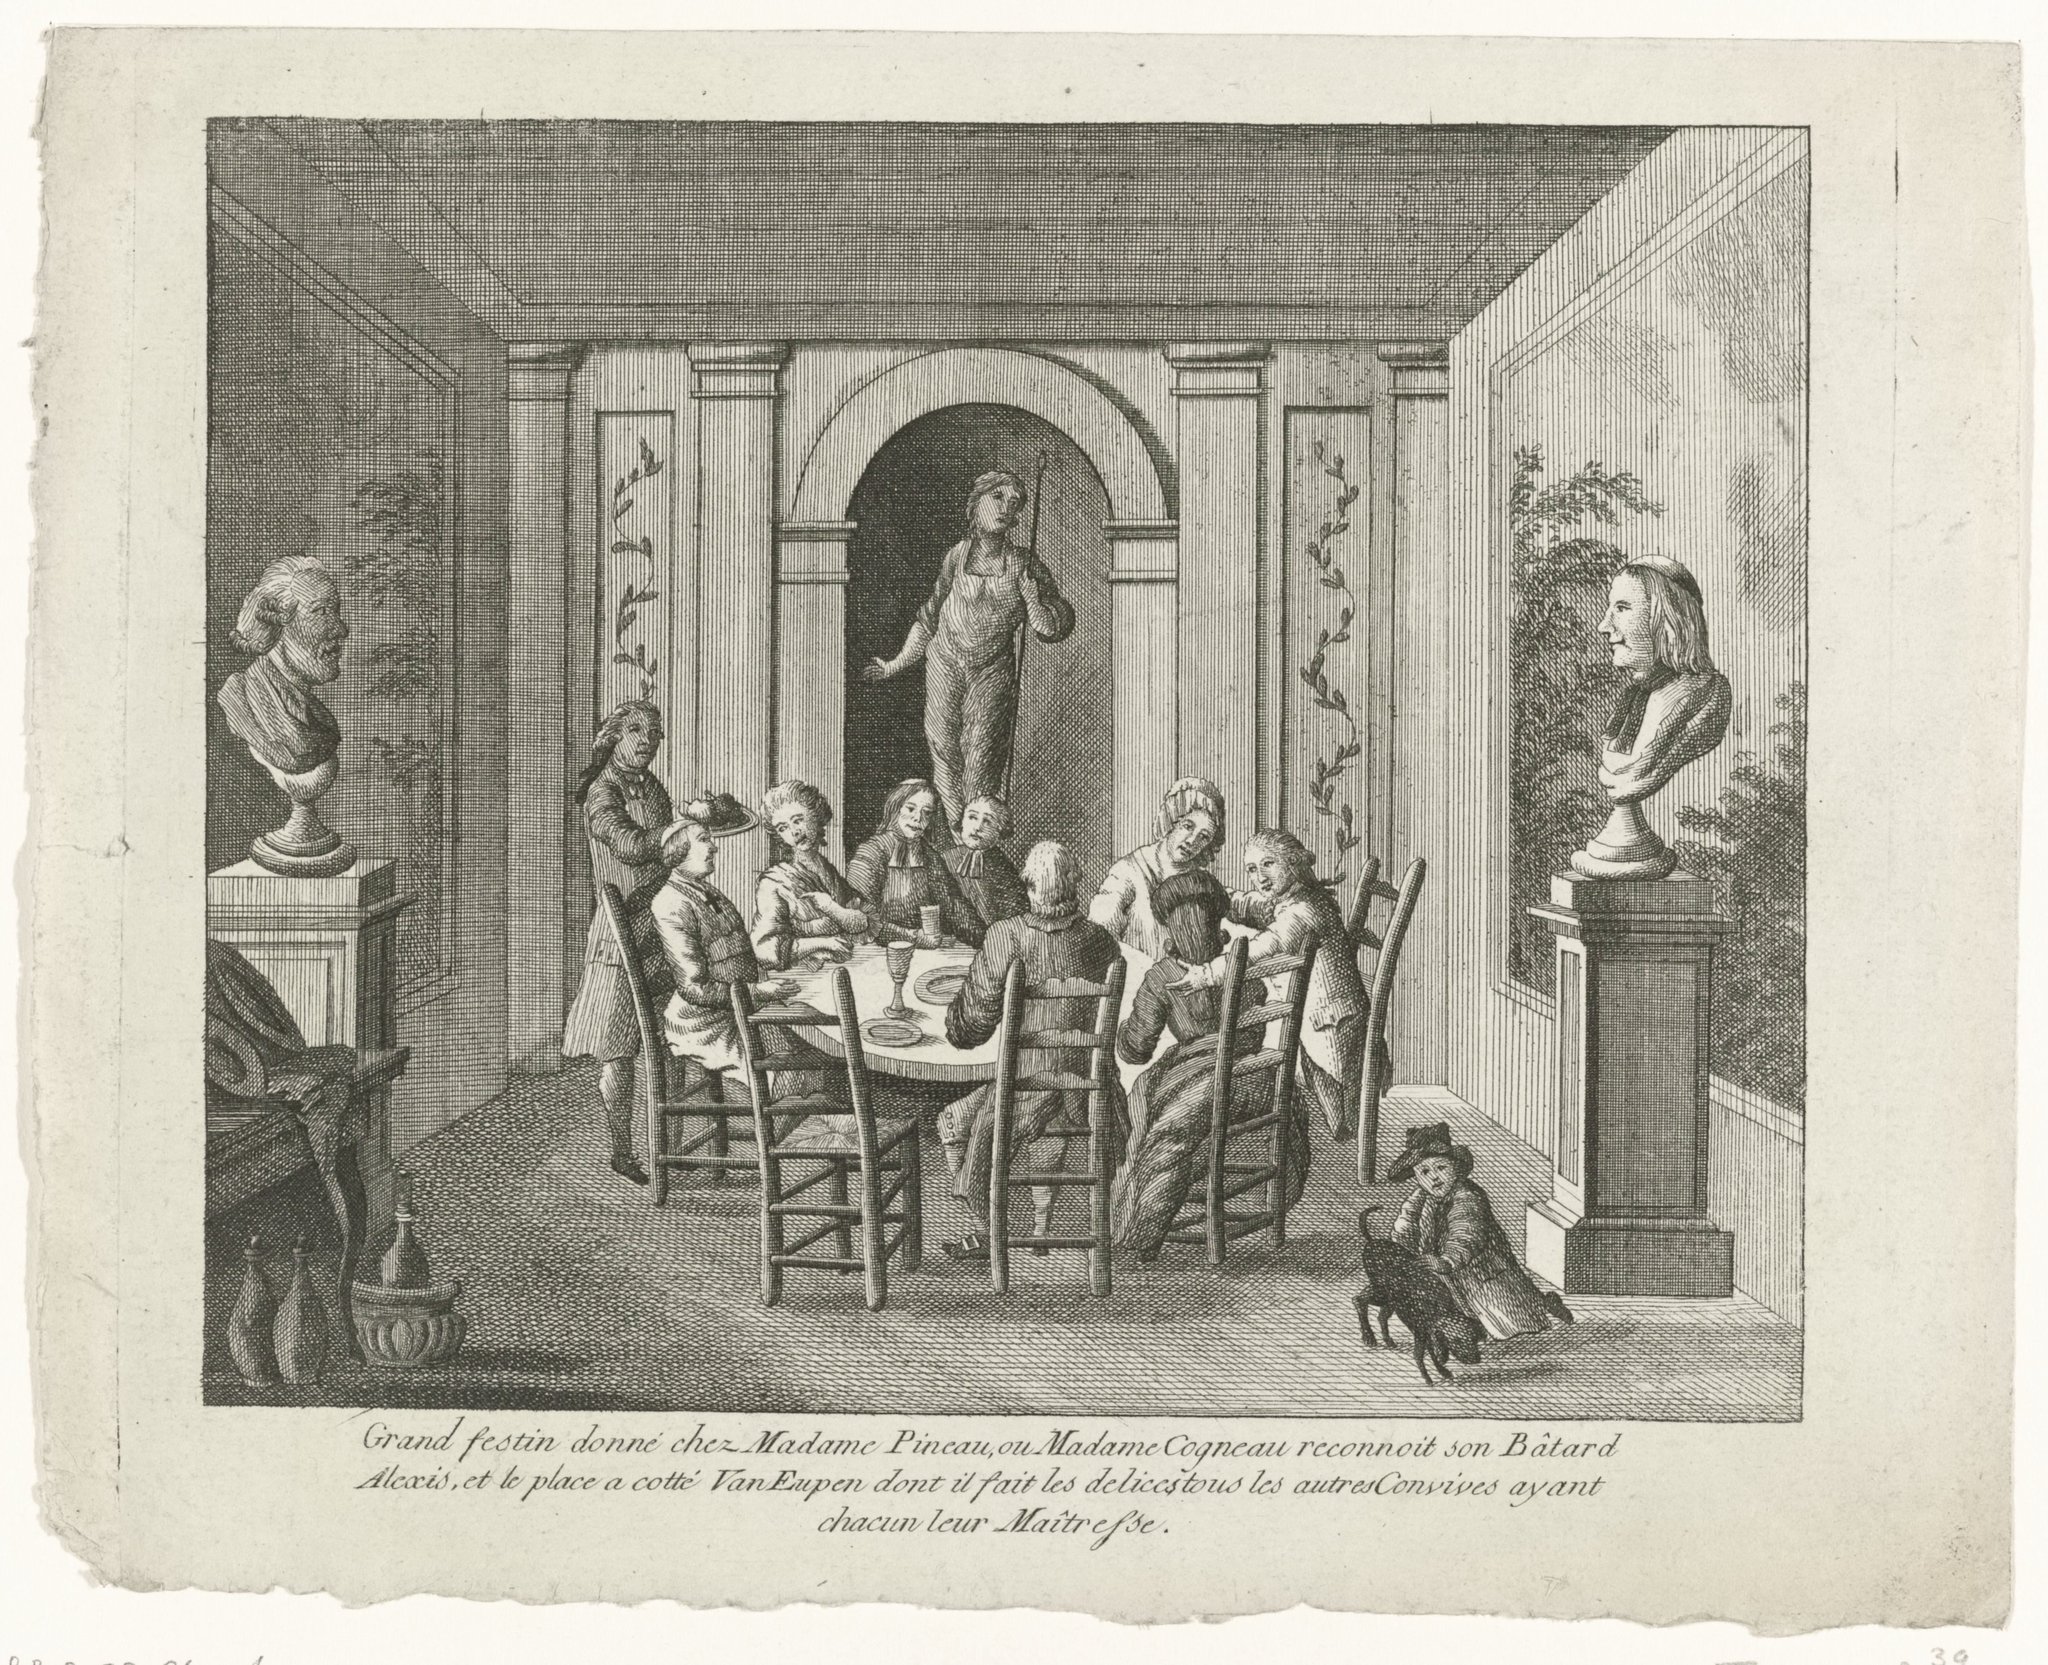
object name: print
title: Feestmaal bij Madame Pineau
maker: Anonymous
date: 1787-1790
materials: paper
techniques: engraving, etching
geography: southern netherlands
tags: antwerp, priest, brabant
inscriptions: collector's mark: Lugt 2228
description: Interieur van een salon bij Madame Pineau (of Pinau) waar een feestmaal gehouden wordt. Aan tafel zitten genodigden, waaronder Van Eupen, met hun maîtresses. Onderdeel van een grote groep van prenten betrekking hebbend op de gebeurtenissen van de Brabantse Omwenteling en de periode 1787-1790.